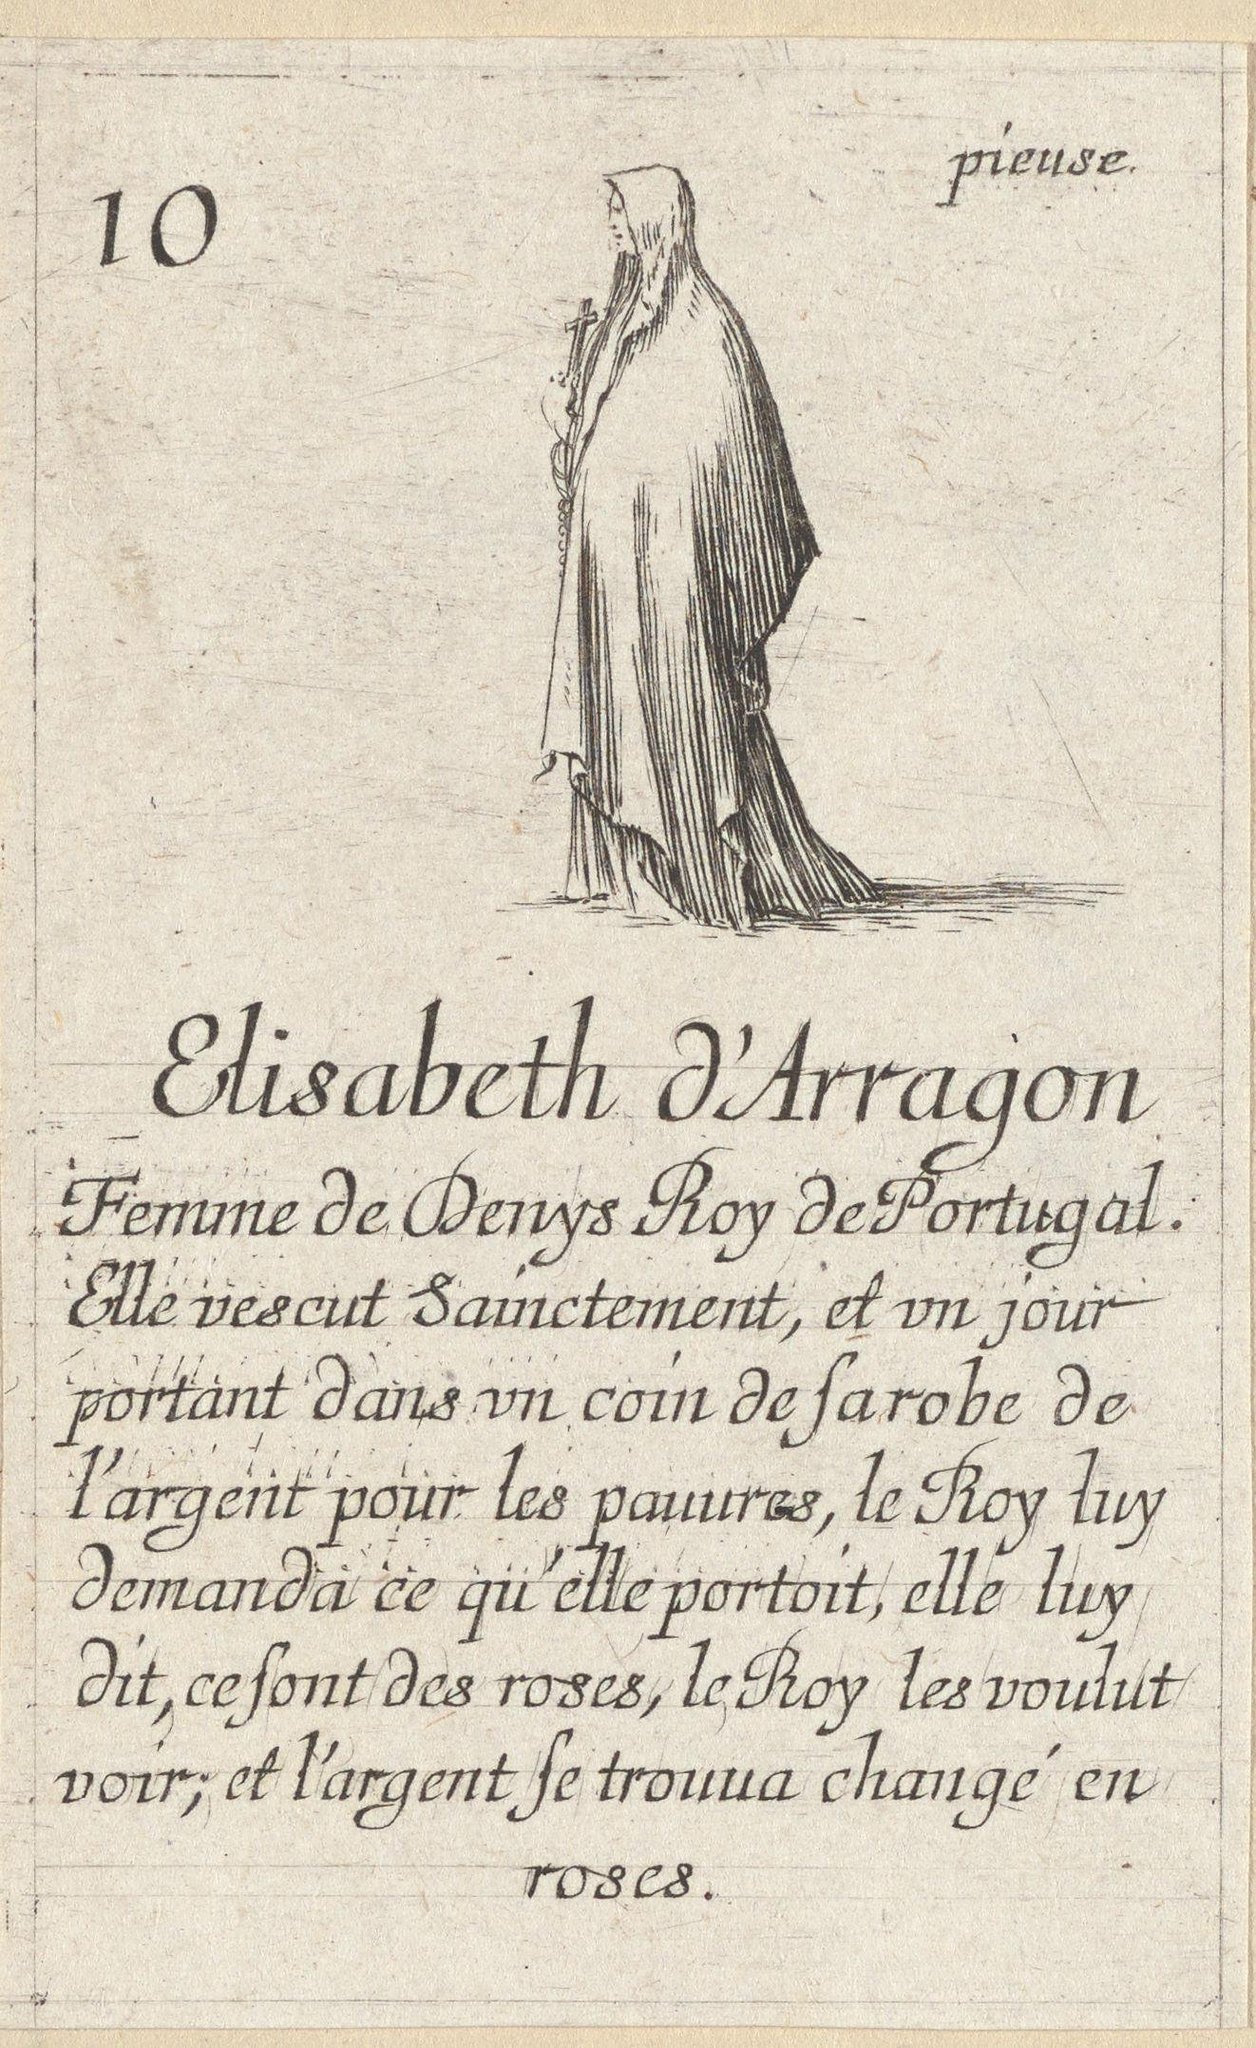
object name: playing card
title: Jeu des reynes renommées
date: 1620-1664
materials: paper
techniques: etching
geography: paris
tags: ruler, sovereign - bb - female ruler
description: Deze prent maakt deel uit van een kaartspel met 52 kaarten met voorstellingen van beroemde koninginnen. De serie is uitgedacht door Jean Desmarests de Saint-Sorlin in opdracht van Kardinaal Mazarin. Het kaartspel werd gemaakt voor de jonge Lodewijk XIV, samen met het Jeu des Fables, Jeu de la Géographie en Jeu des Rois de France.